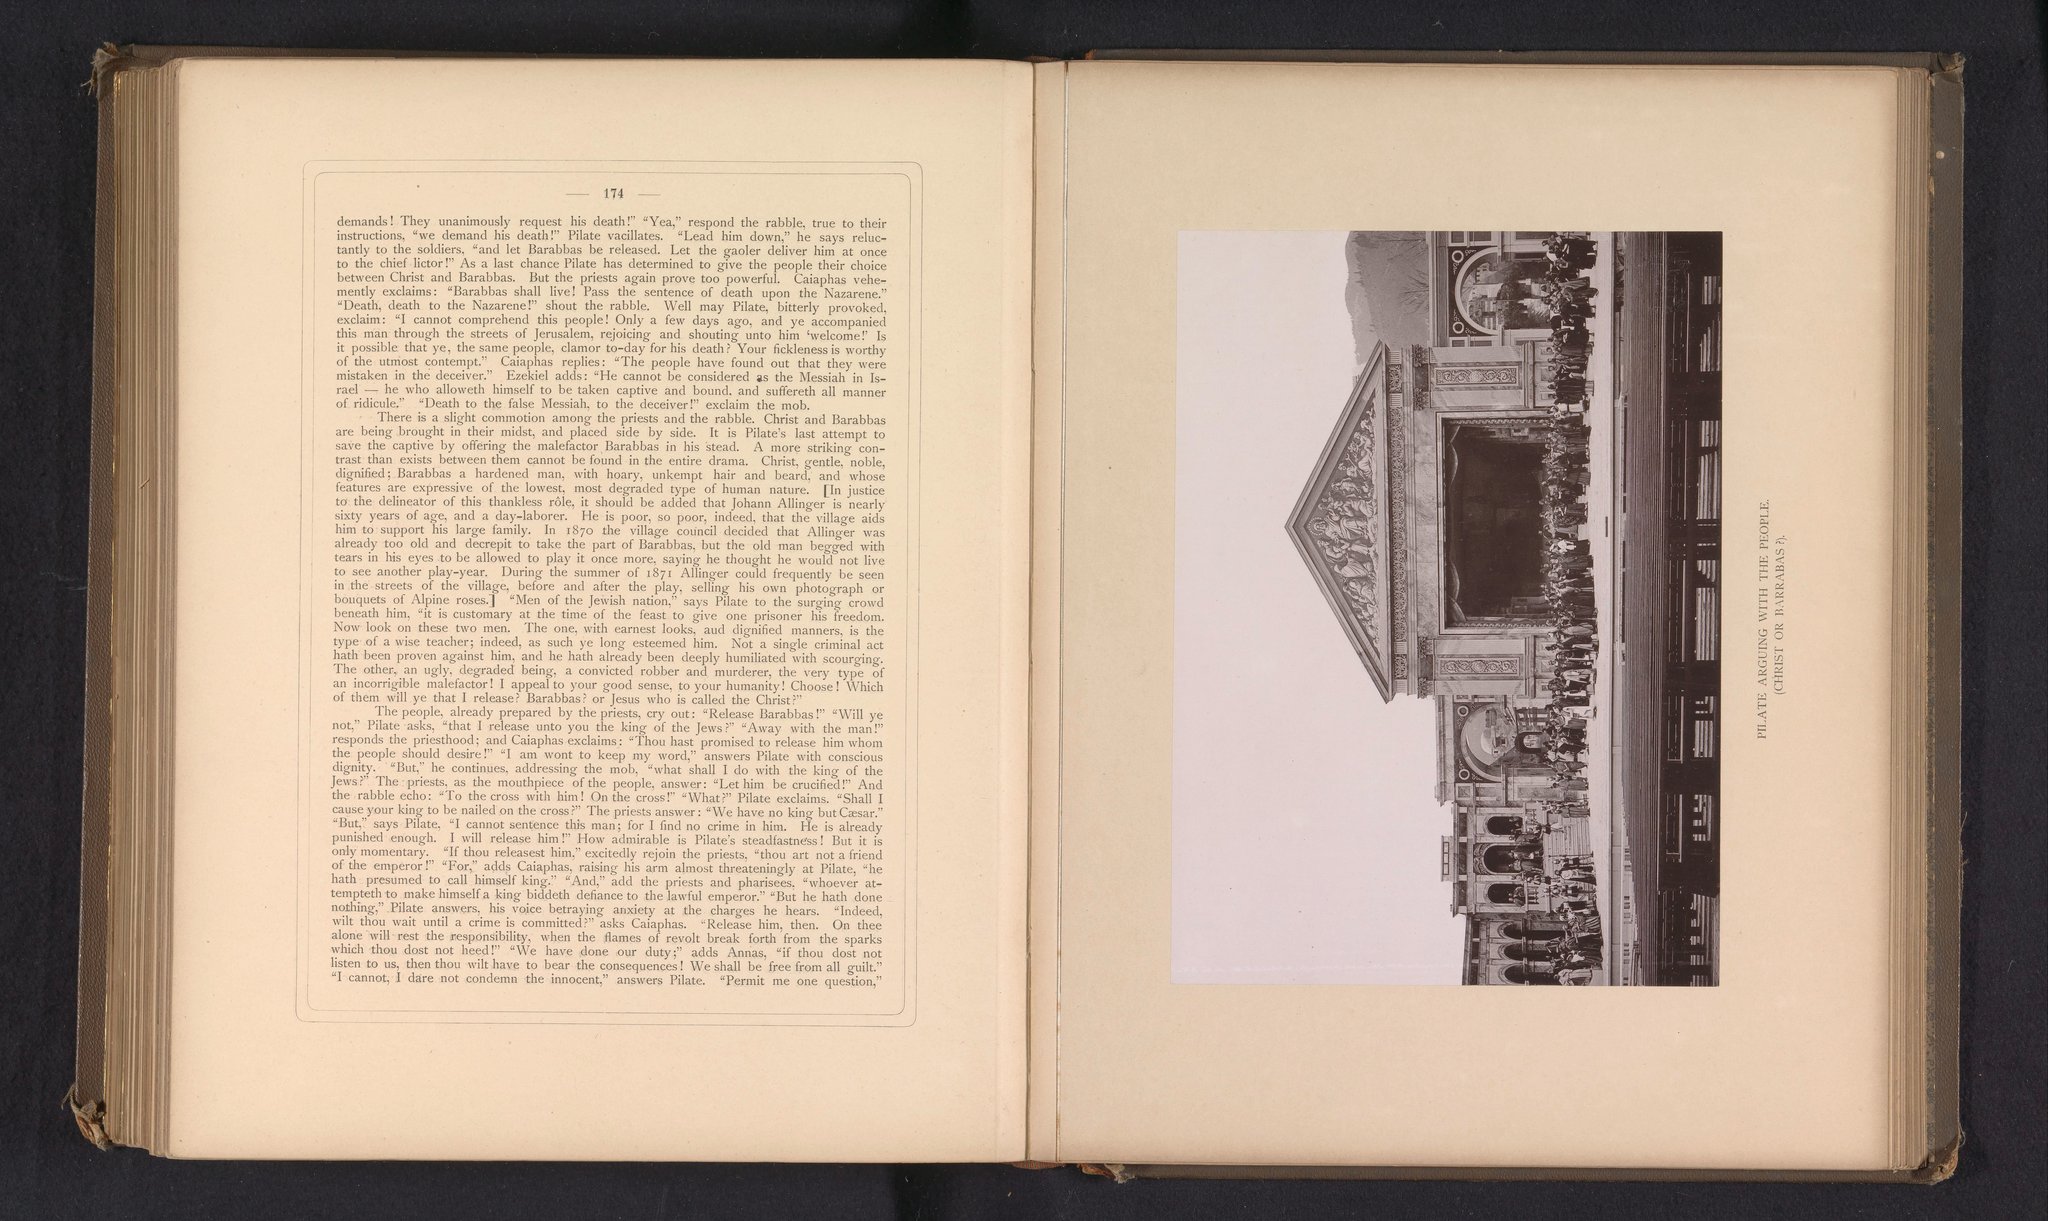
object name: photomechanical print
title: Pilate arguing with the people (Christ or Barrabas?)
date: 1885-1890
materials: paper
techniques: photograph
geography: oberammergau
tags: choice between christ and barabbas, group of actors, troupe; actors on the stage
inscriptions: inscription: ‘Gemeinde Oberammergau Passionsspiel 1890’